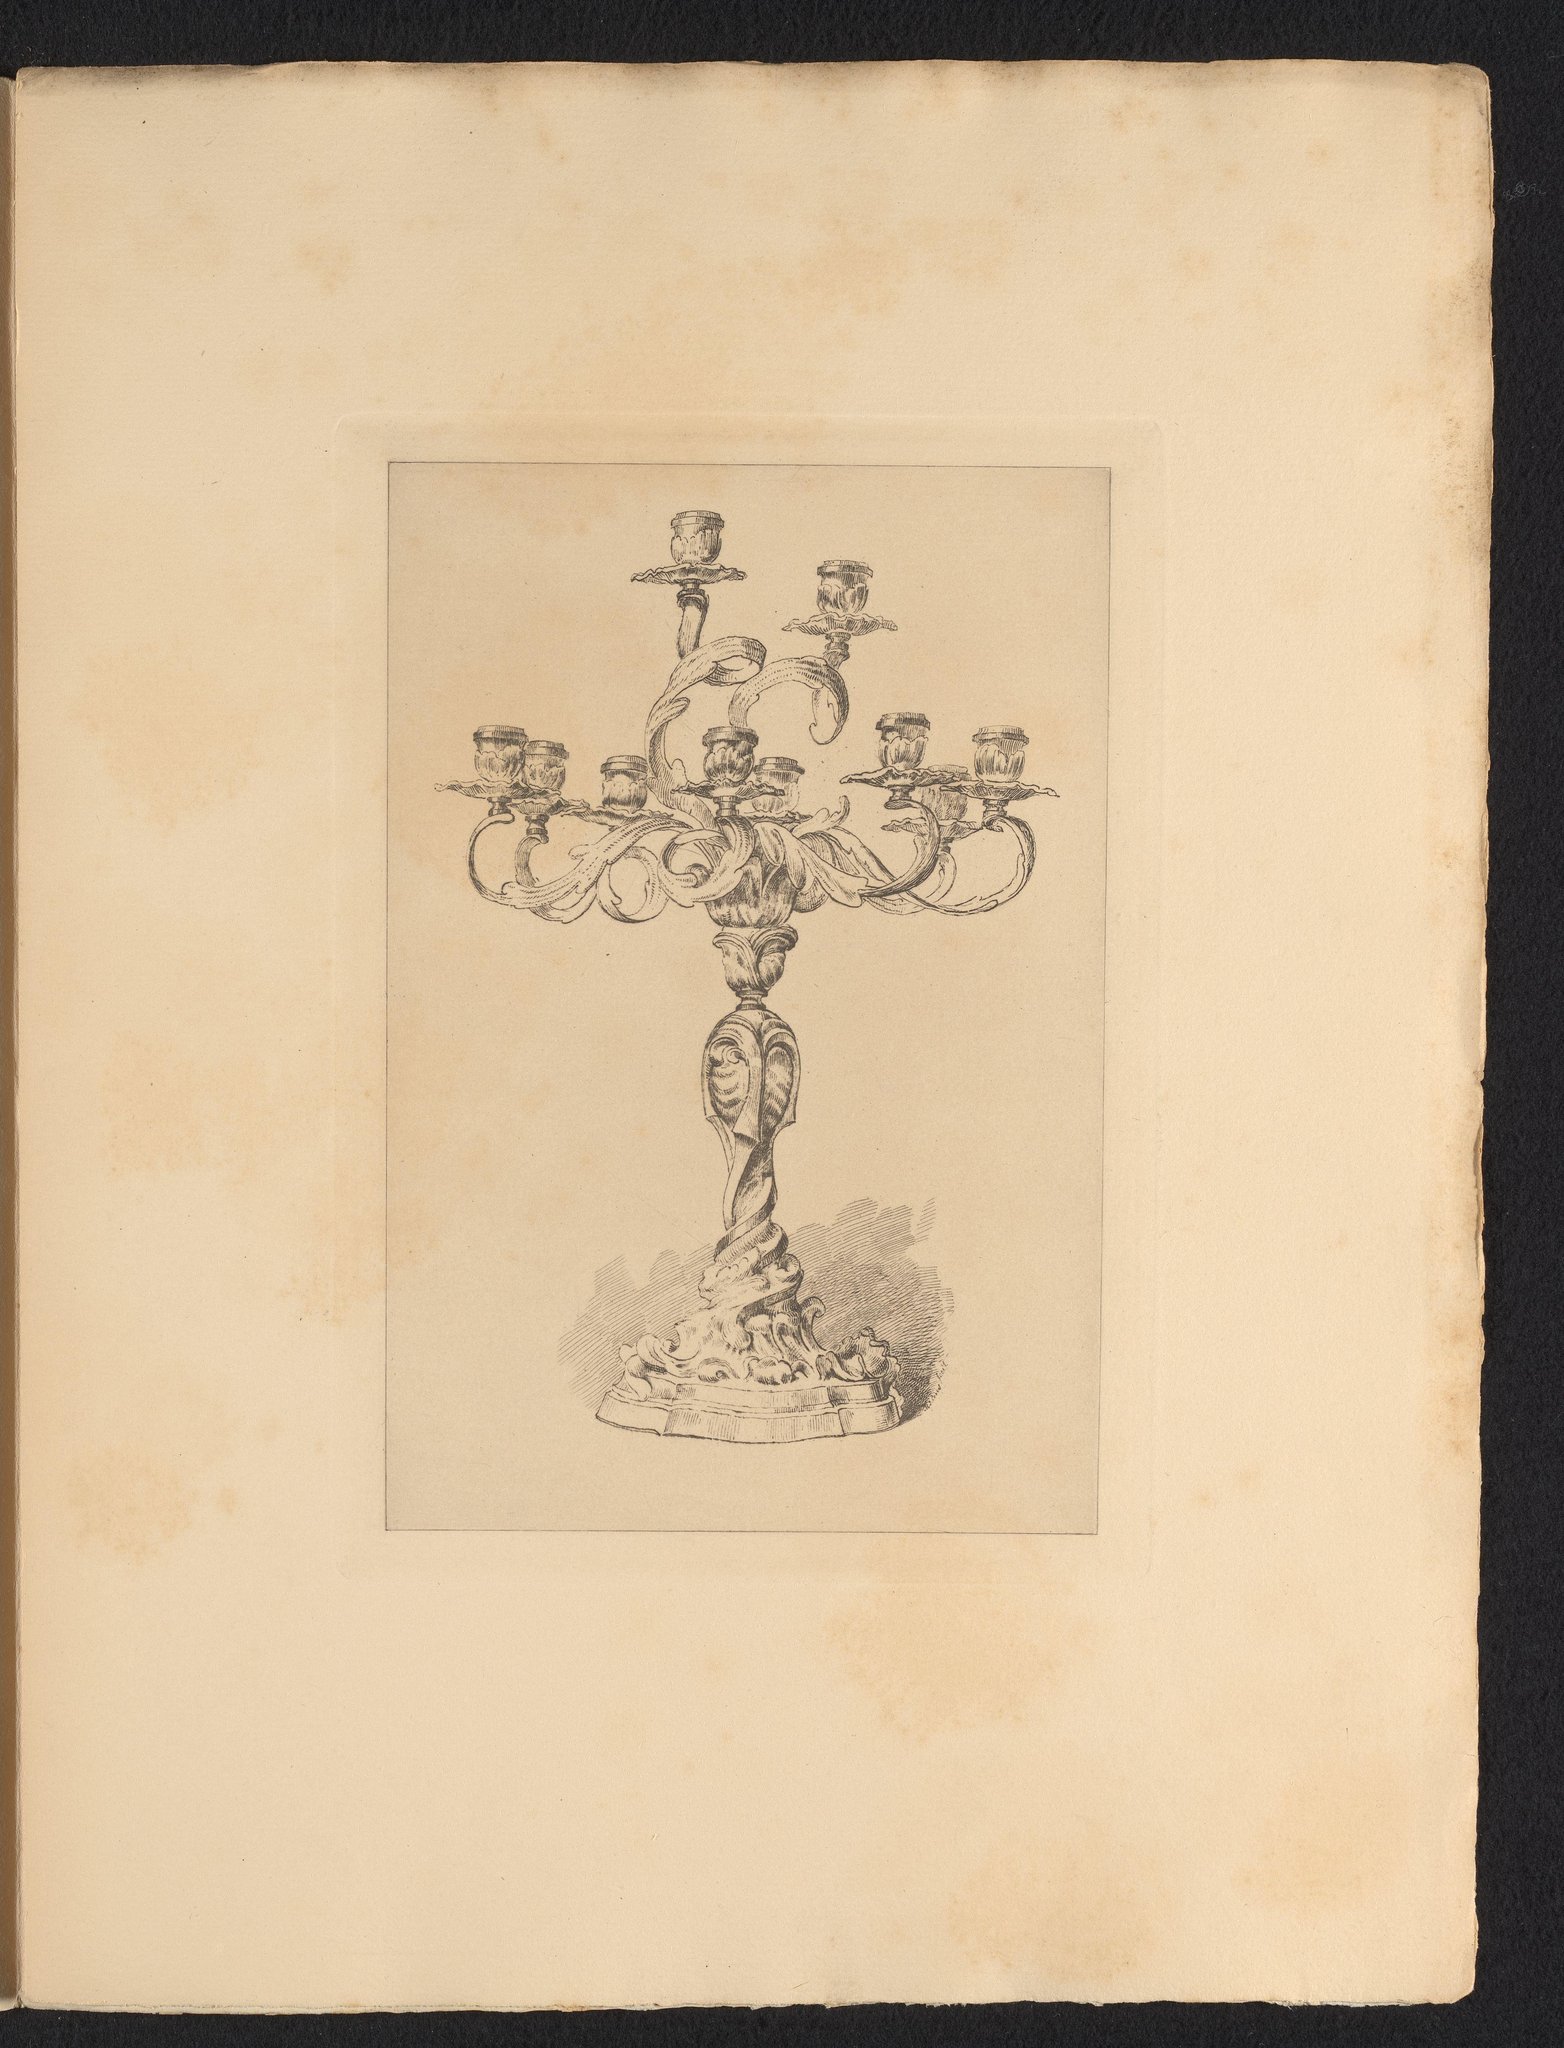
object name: print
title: Tienarmige zilveren kandelaar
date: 1889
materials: paper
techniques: etching, intaglio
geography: utrecht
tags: candlestick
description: Prent maakt deel uit van een serie van veertien prenten.